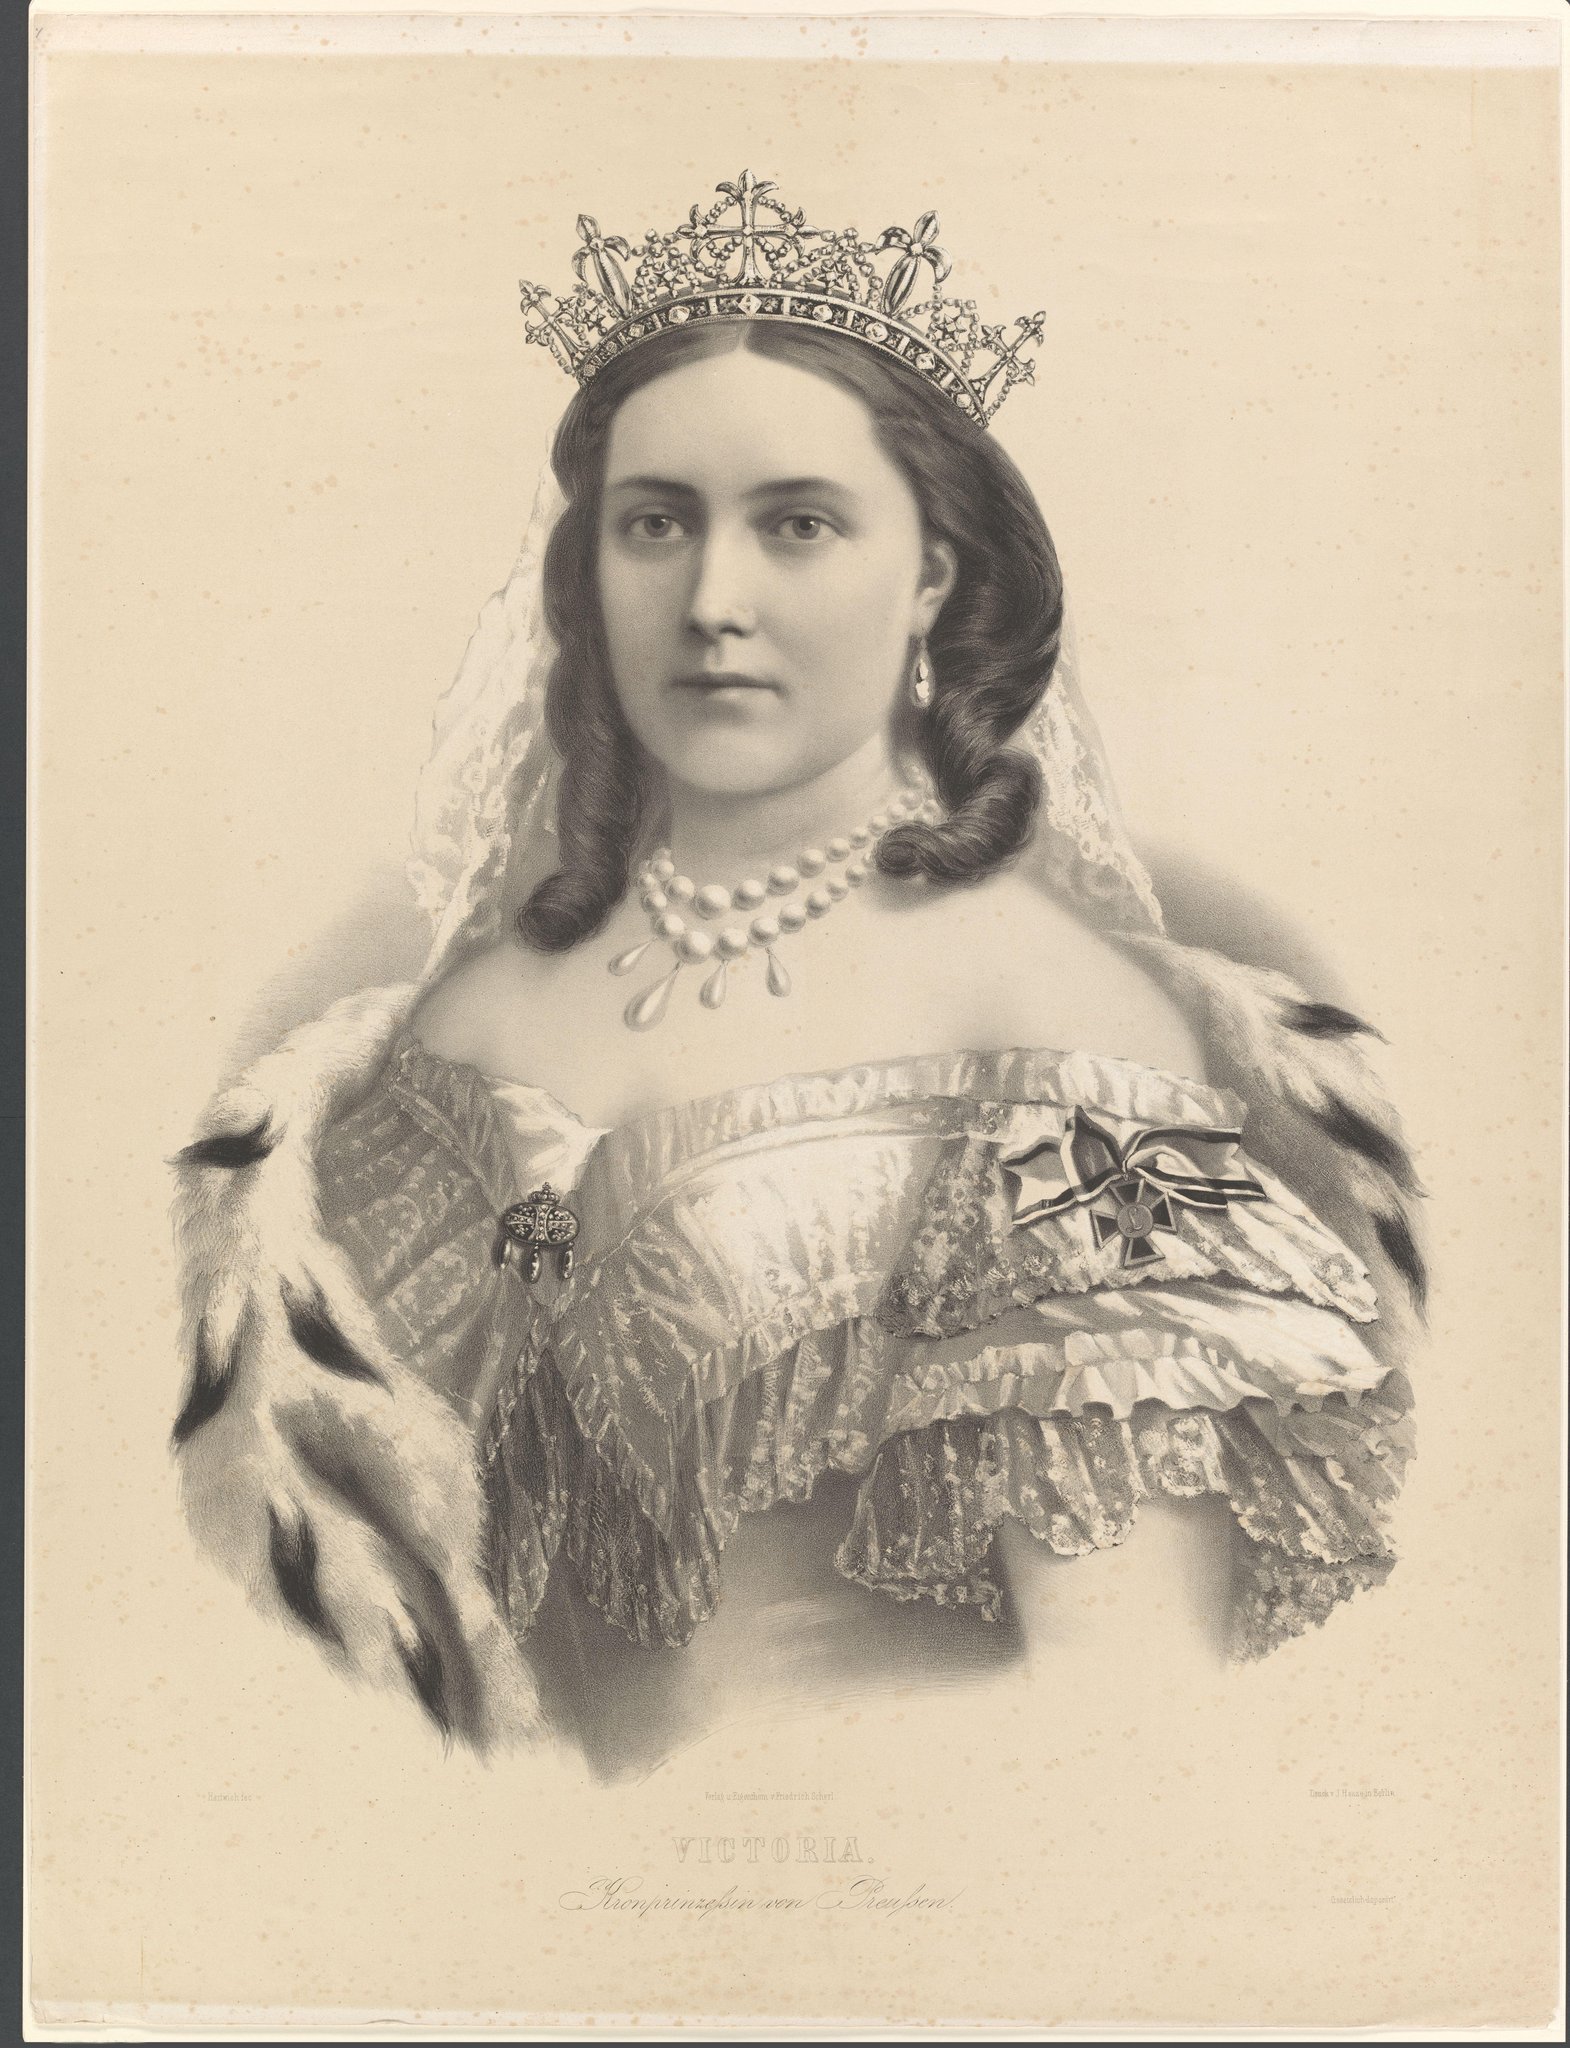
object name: print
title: Portret van Victoria, keizerin van Duitsland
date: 1860-1899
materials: paper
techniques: tone lithography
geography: berlin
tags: victoria van saksen-coburg en gotha (duits keizerin), adult woman, historical persons, insignia and symbols of sovereignty (crown, diadem, sceptre, orb, seal, standard, cloak, pectoral)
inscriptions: collector's mark: Lugt 2228